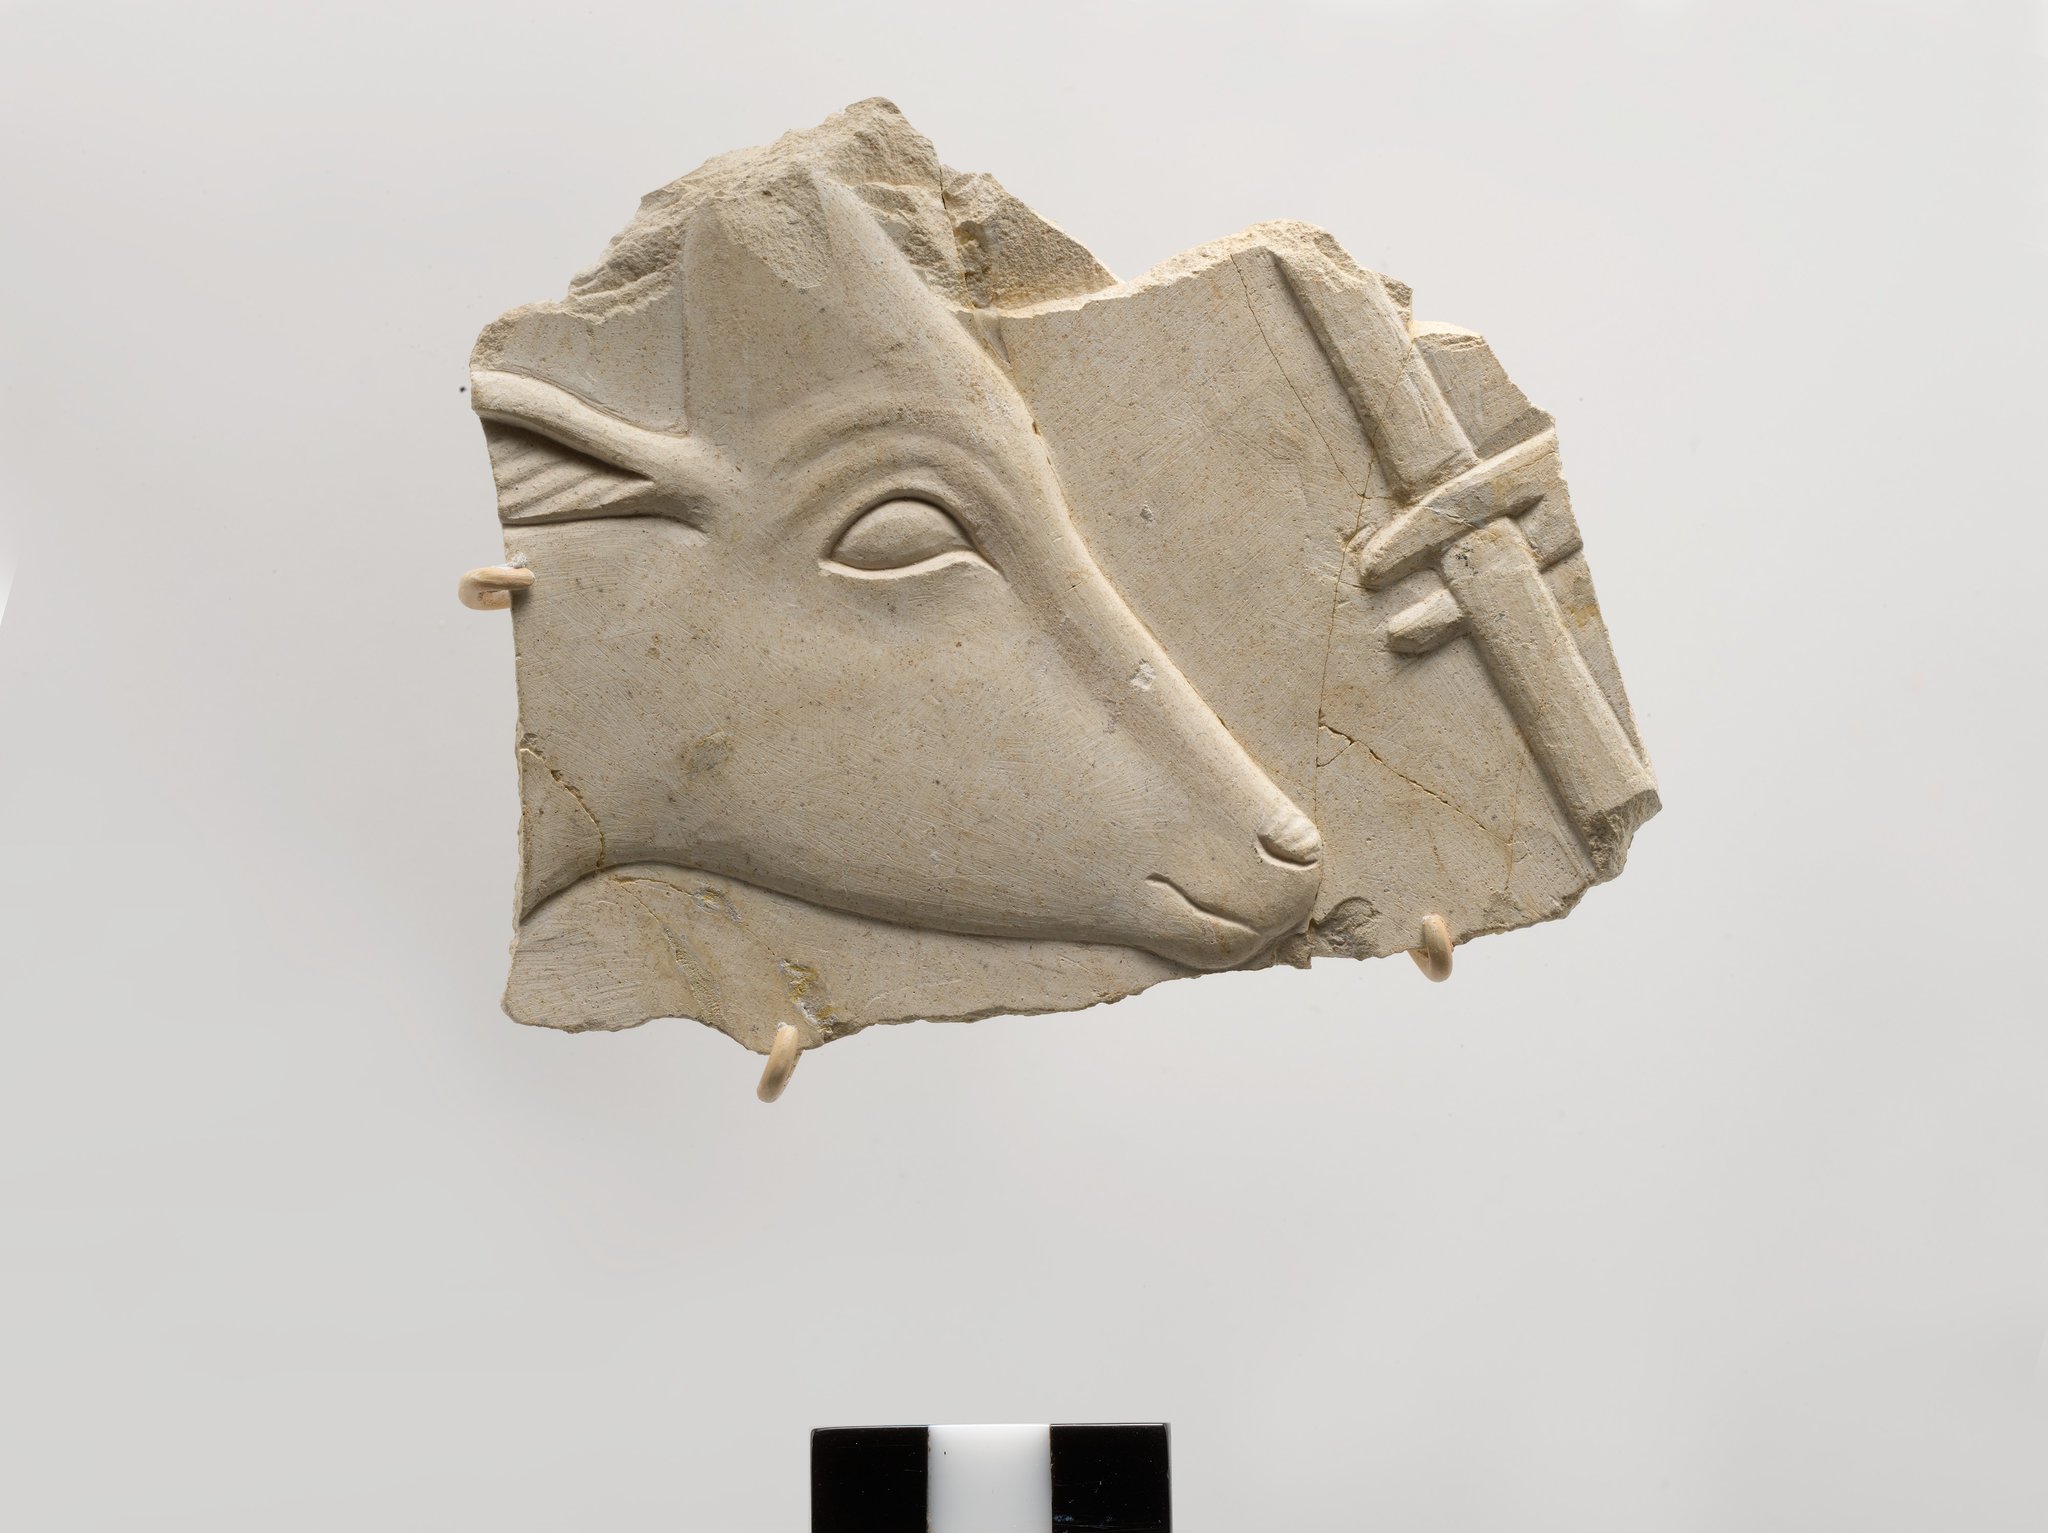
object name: relief fragment, tomb of meketre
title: Relief fragment from the tomb of Meketre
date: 1981-1975 BCE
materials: limestone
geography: egypt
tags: animals